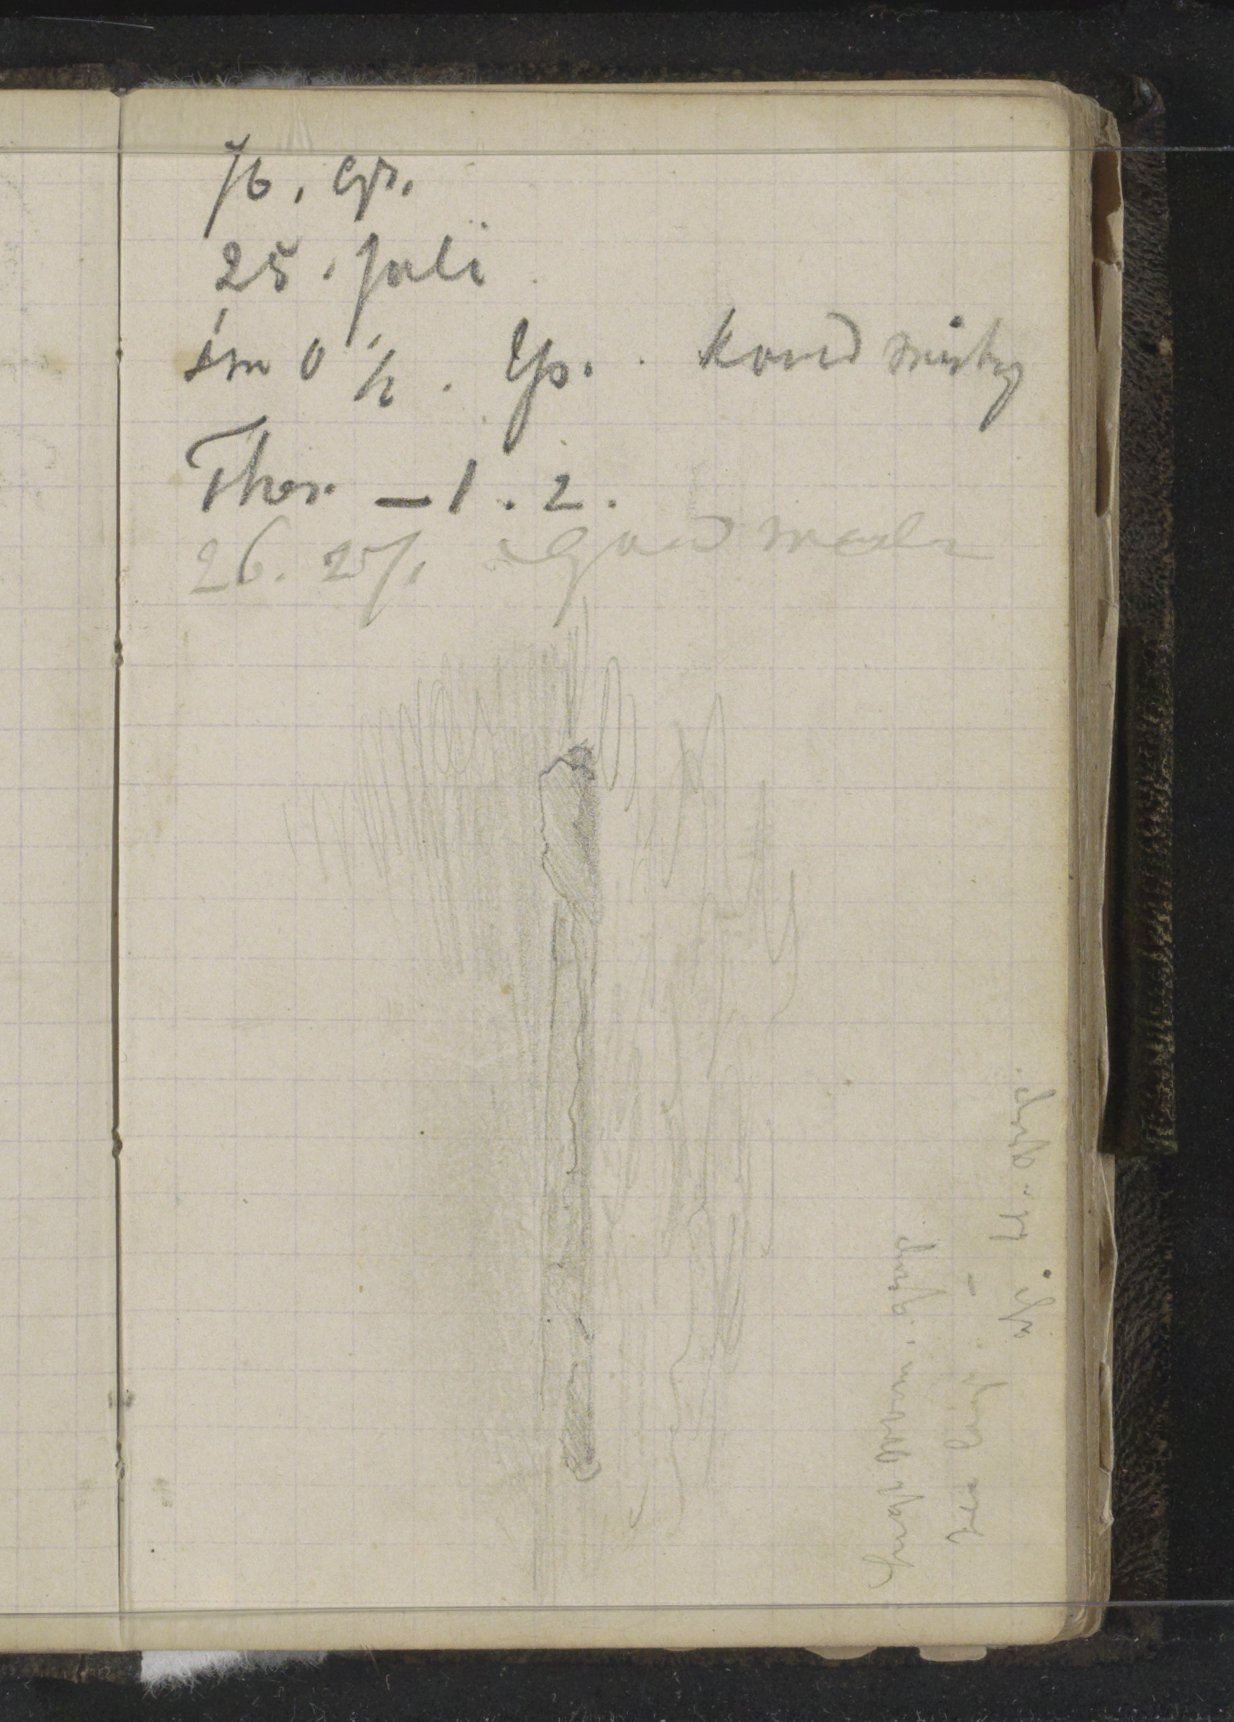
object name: sketchbook leaf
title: Gezicht op een ijsberg of ijsschots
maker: louis apol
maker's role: draughtsman, painter, print maker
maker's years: 1850-1936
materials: pencil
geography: novaya zemlya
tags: iceberg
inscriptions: annotation: ‘[...]’, : ‘[...]’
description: Blad 23 recto uit een schetsboek met 110 bladen betekend tijdens de expeditie naar Nova Zembla in 1880.